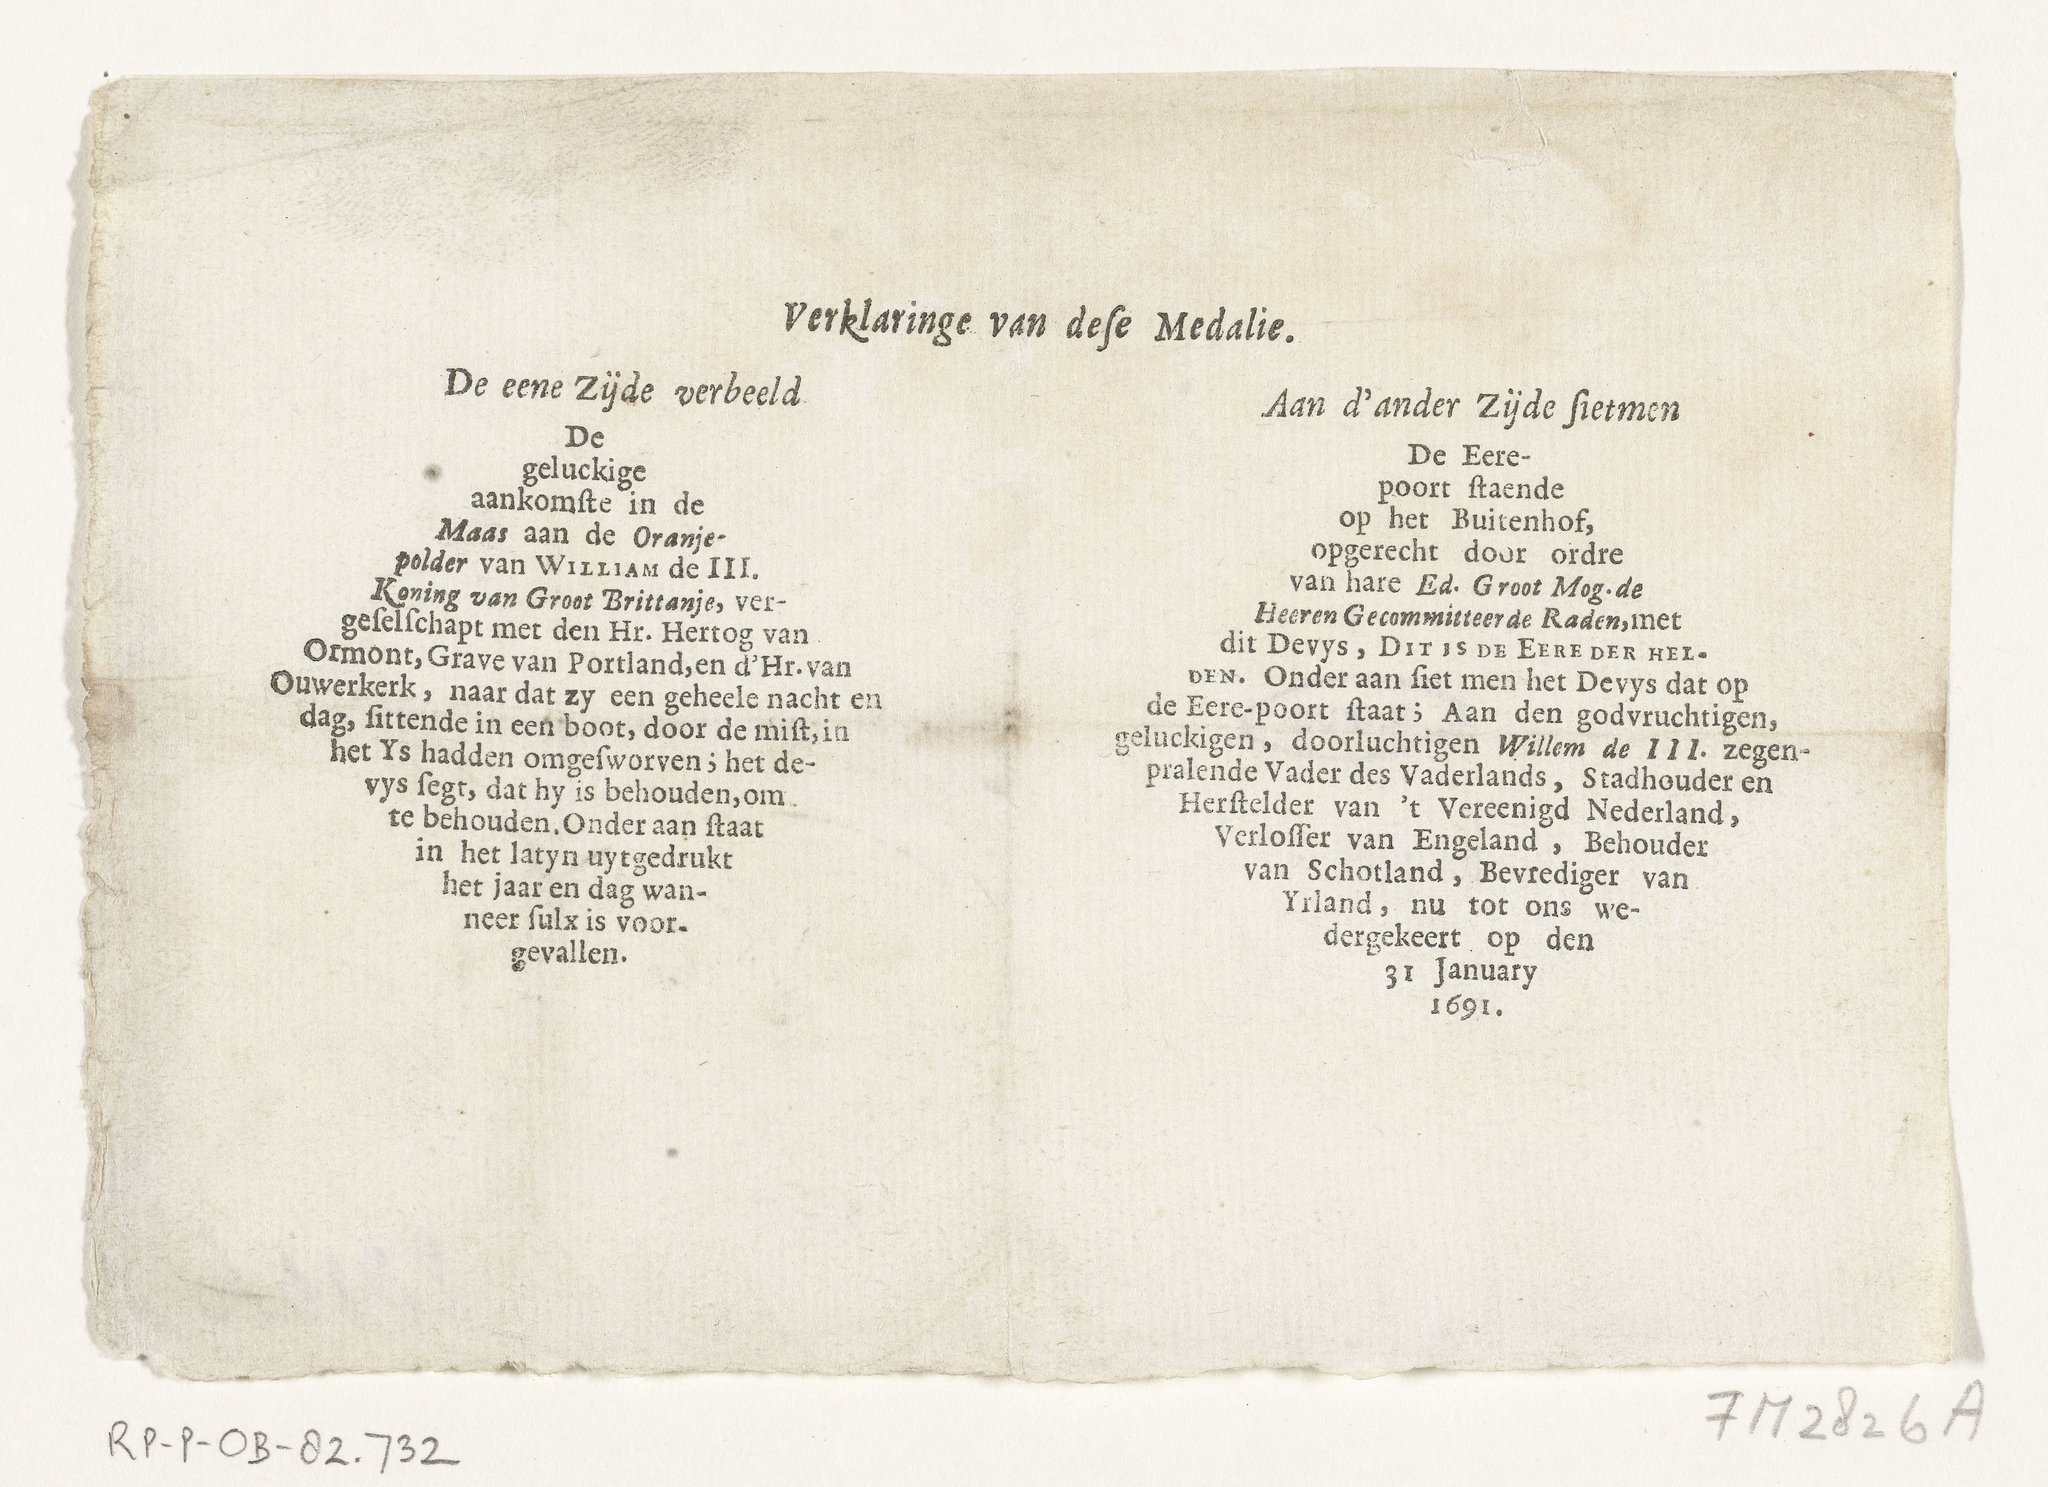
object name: print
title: Beschrijving van de medaille op de gelukkige aankomst van koning Willem III bij Oranjepolder, 1691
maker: Anonymous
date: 1691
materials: paper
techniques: letterpress printing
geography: northern netherlands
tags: the hague, william iii (prince of orange and king of england, scotland, and ireland), medal (considered as a piece of sculpture, regardless of its specific function)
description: Blad met twee ruitvormige beschrijvingen van de beide zijden van de medaille op de gelukkige van de sloep met koning Willem III bij Oranjepolder in Zuid-Holland, 31 januari 1691.